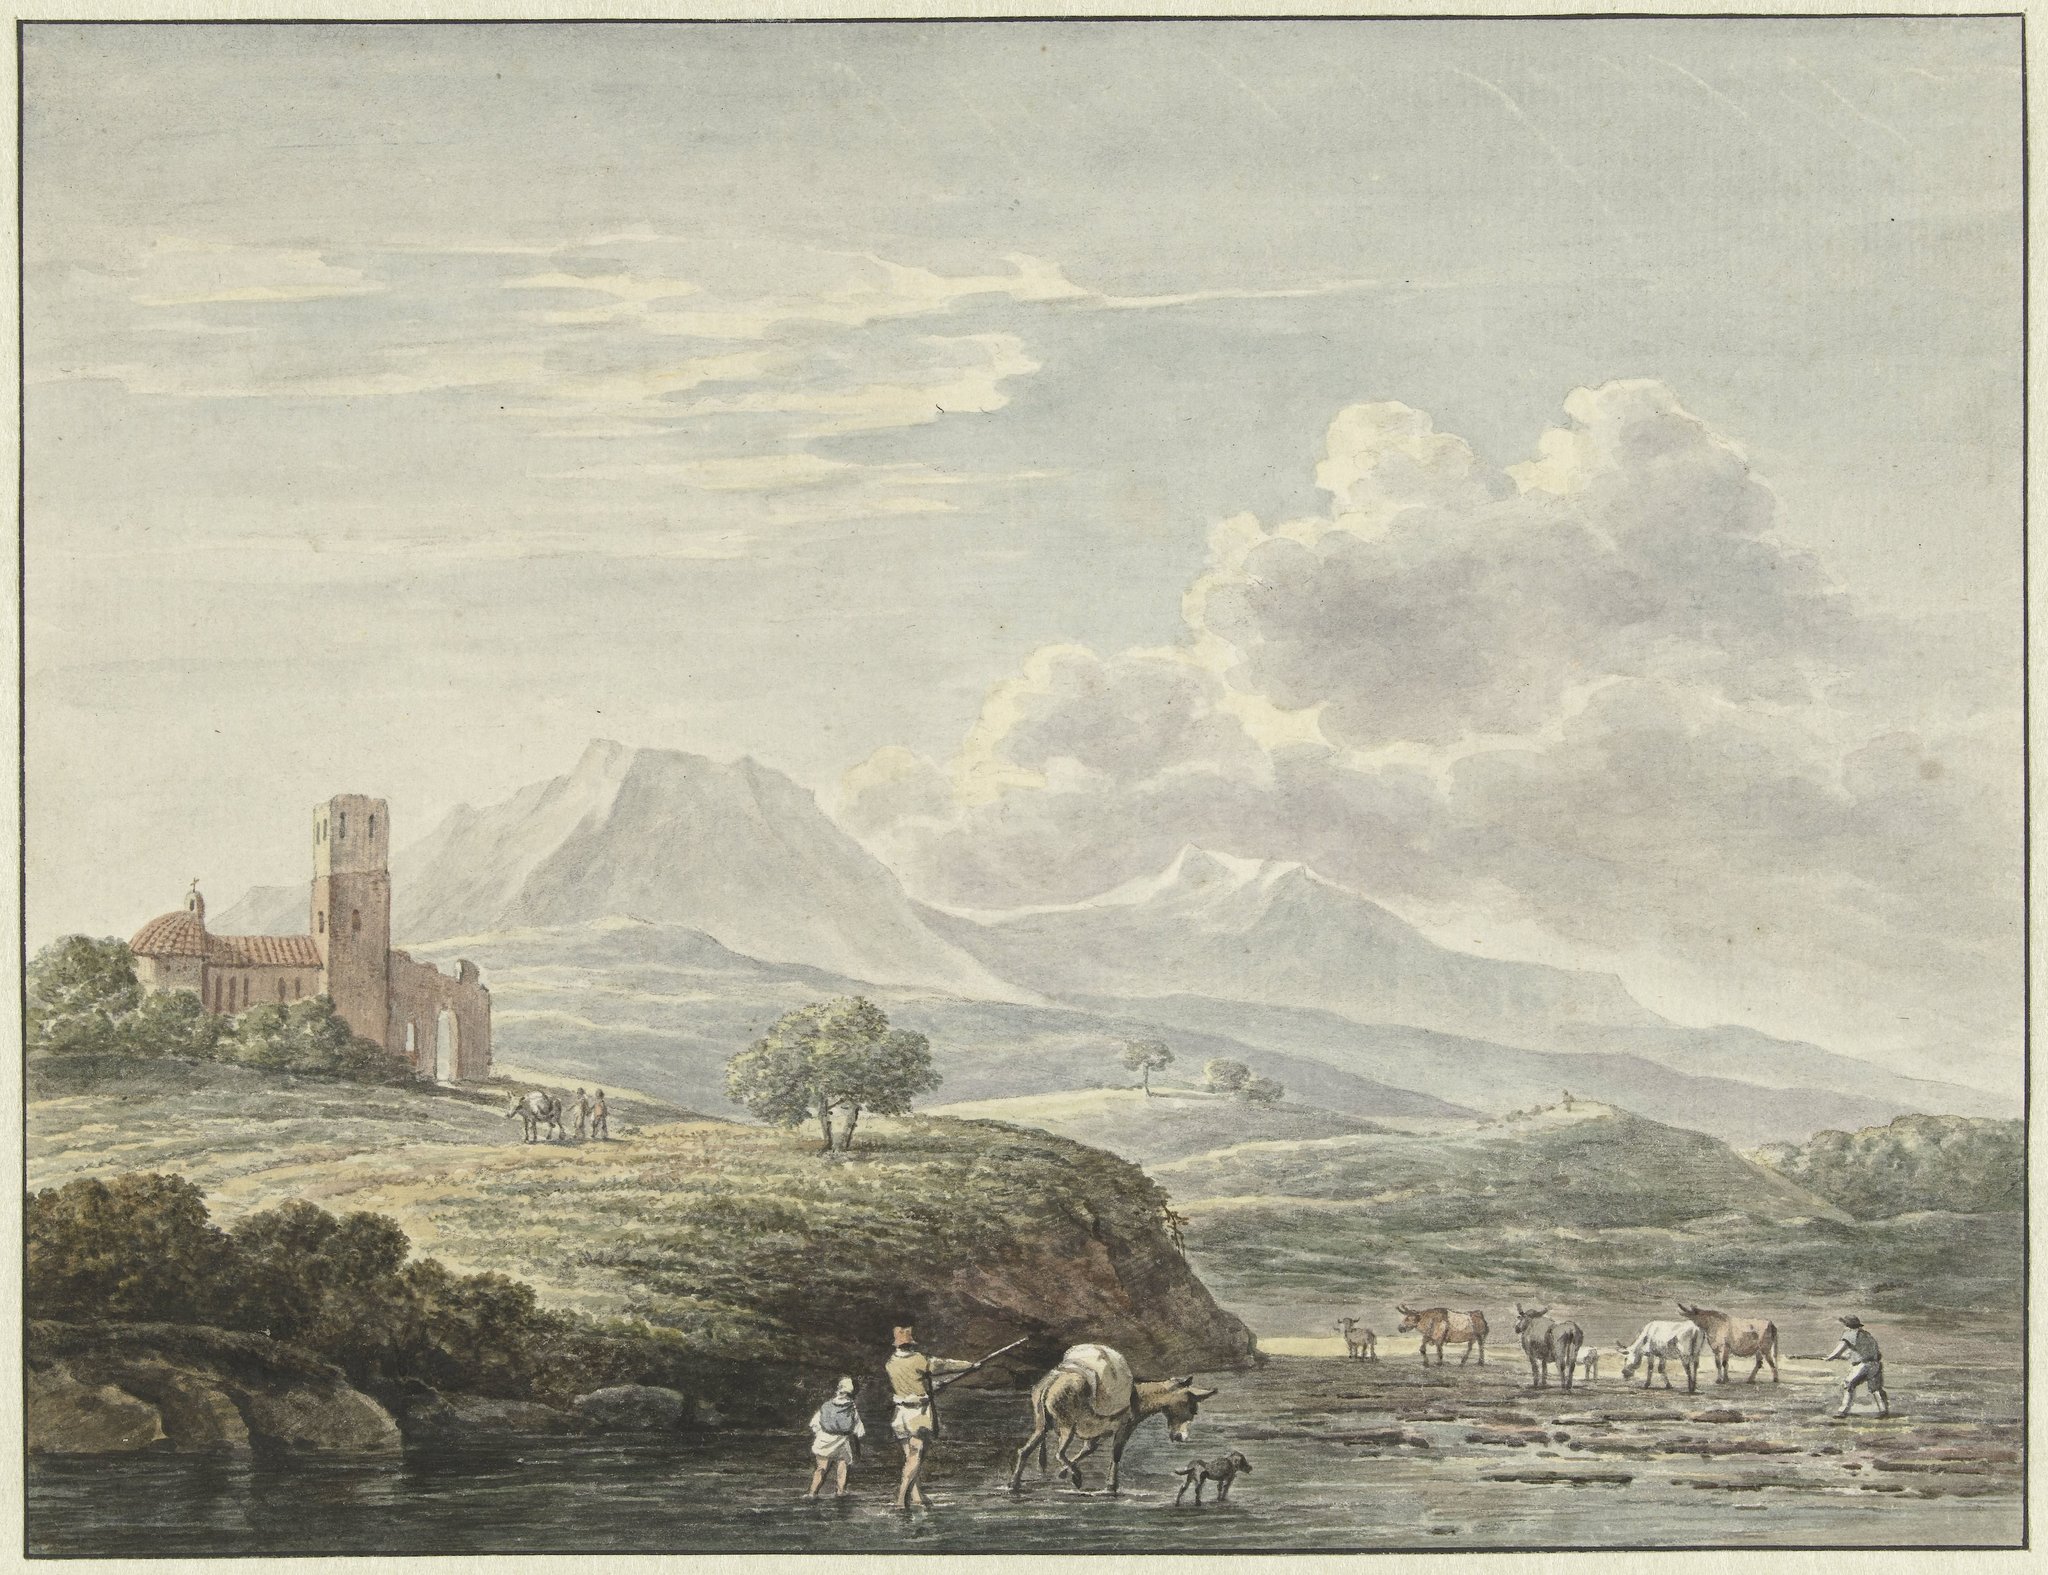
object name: drawing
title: Italiaans landschap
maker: daniël dupré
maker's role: draughtsman, print maker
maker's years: 1751-1817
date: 1761-1800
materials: chalk, ink, paper, watercolor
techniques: brush, pen